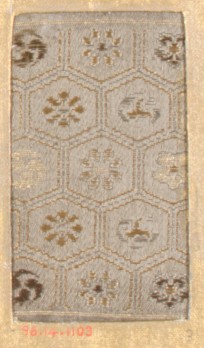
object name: piece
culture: japanese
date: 1701-1900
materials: silk